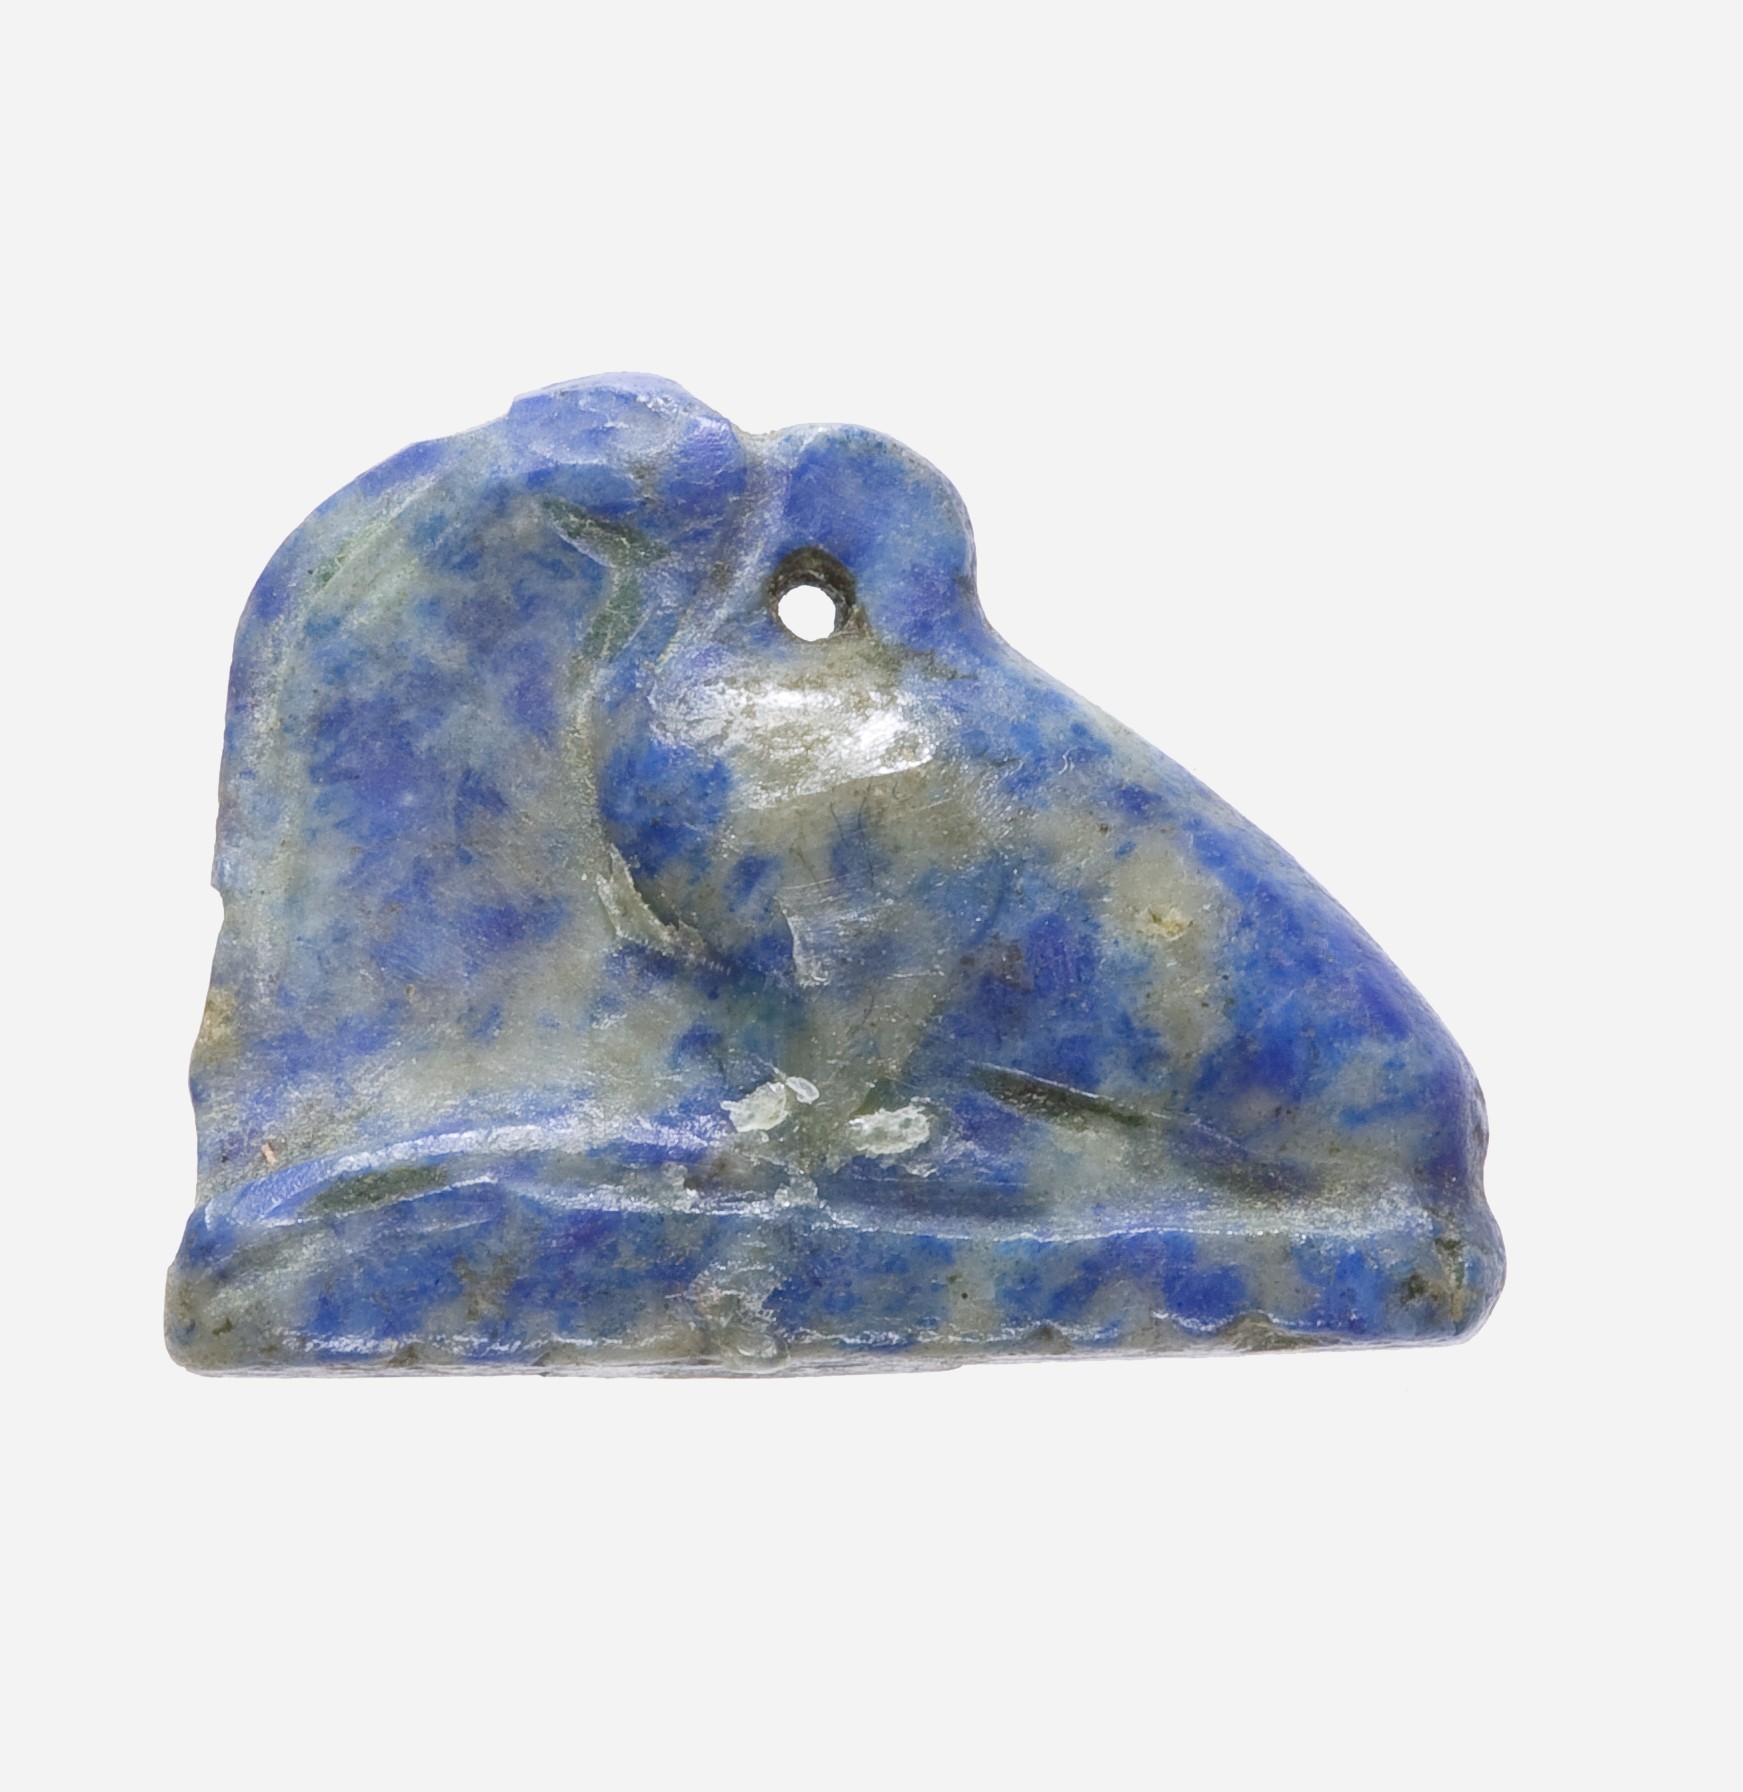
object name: amulet, ibis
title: Ibis Amulet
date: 664-332 BCE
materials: lapis lazuli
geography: egypt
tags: birds